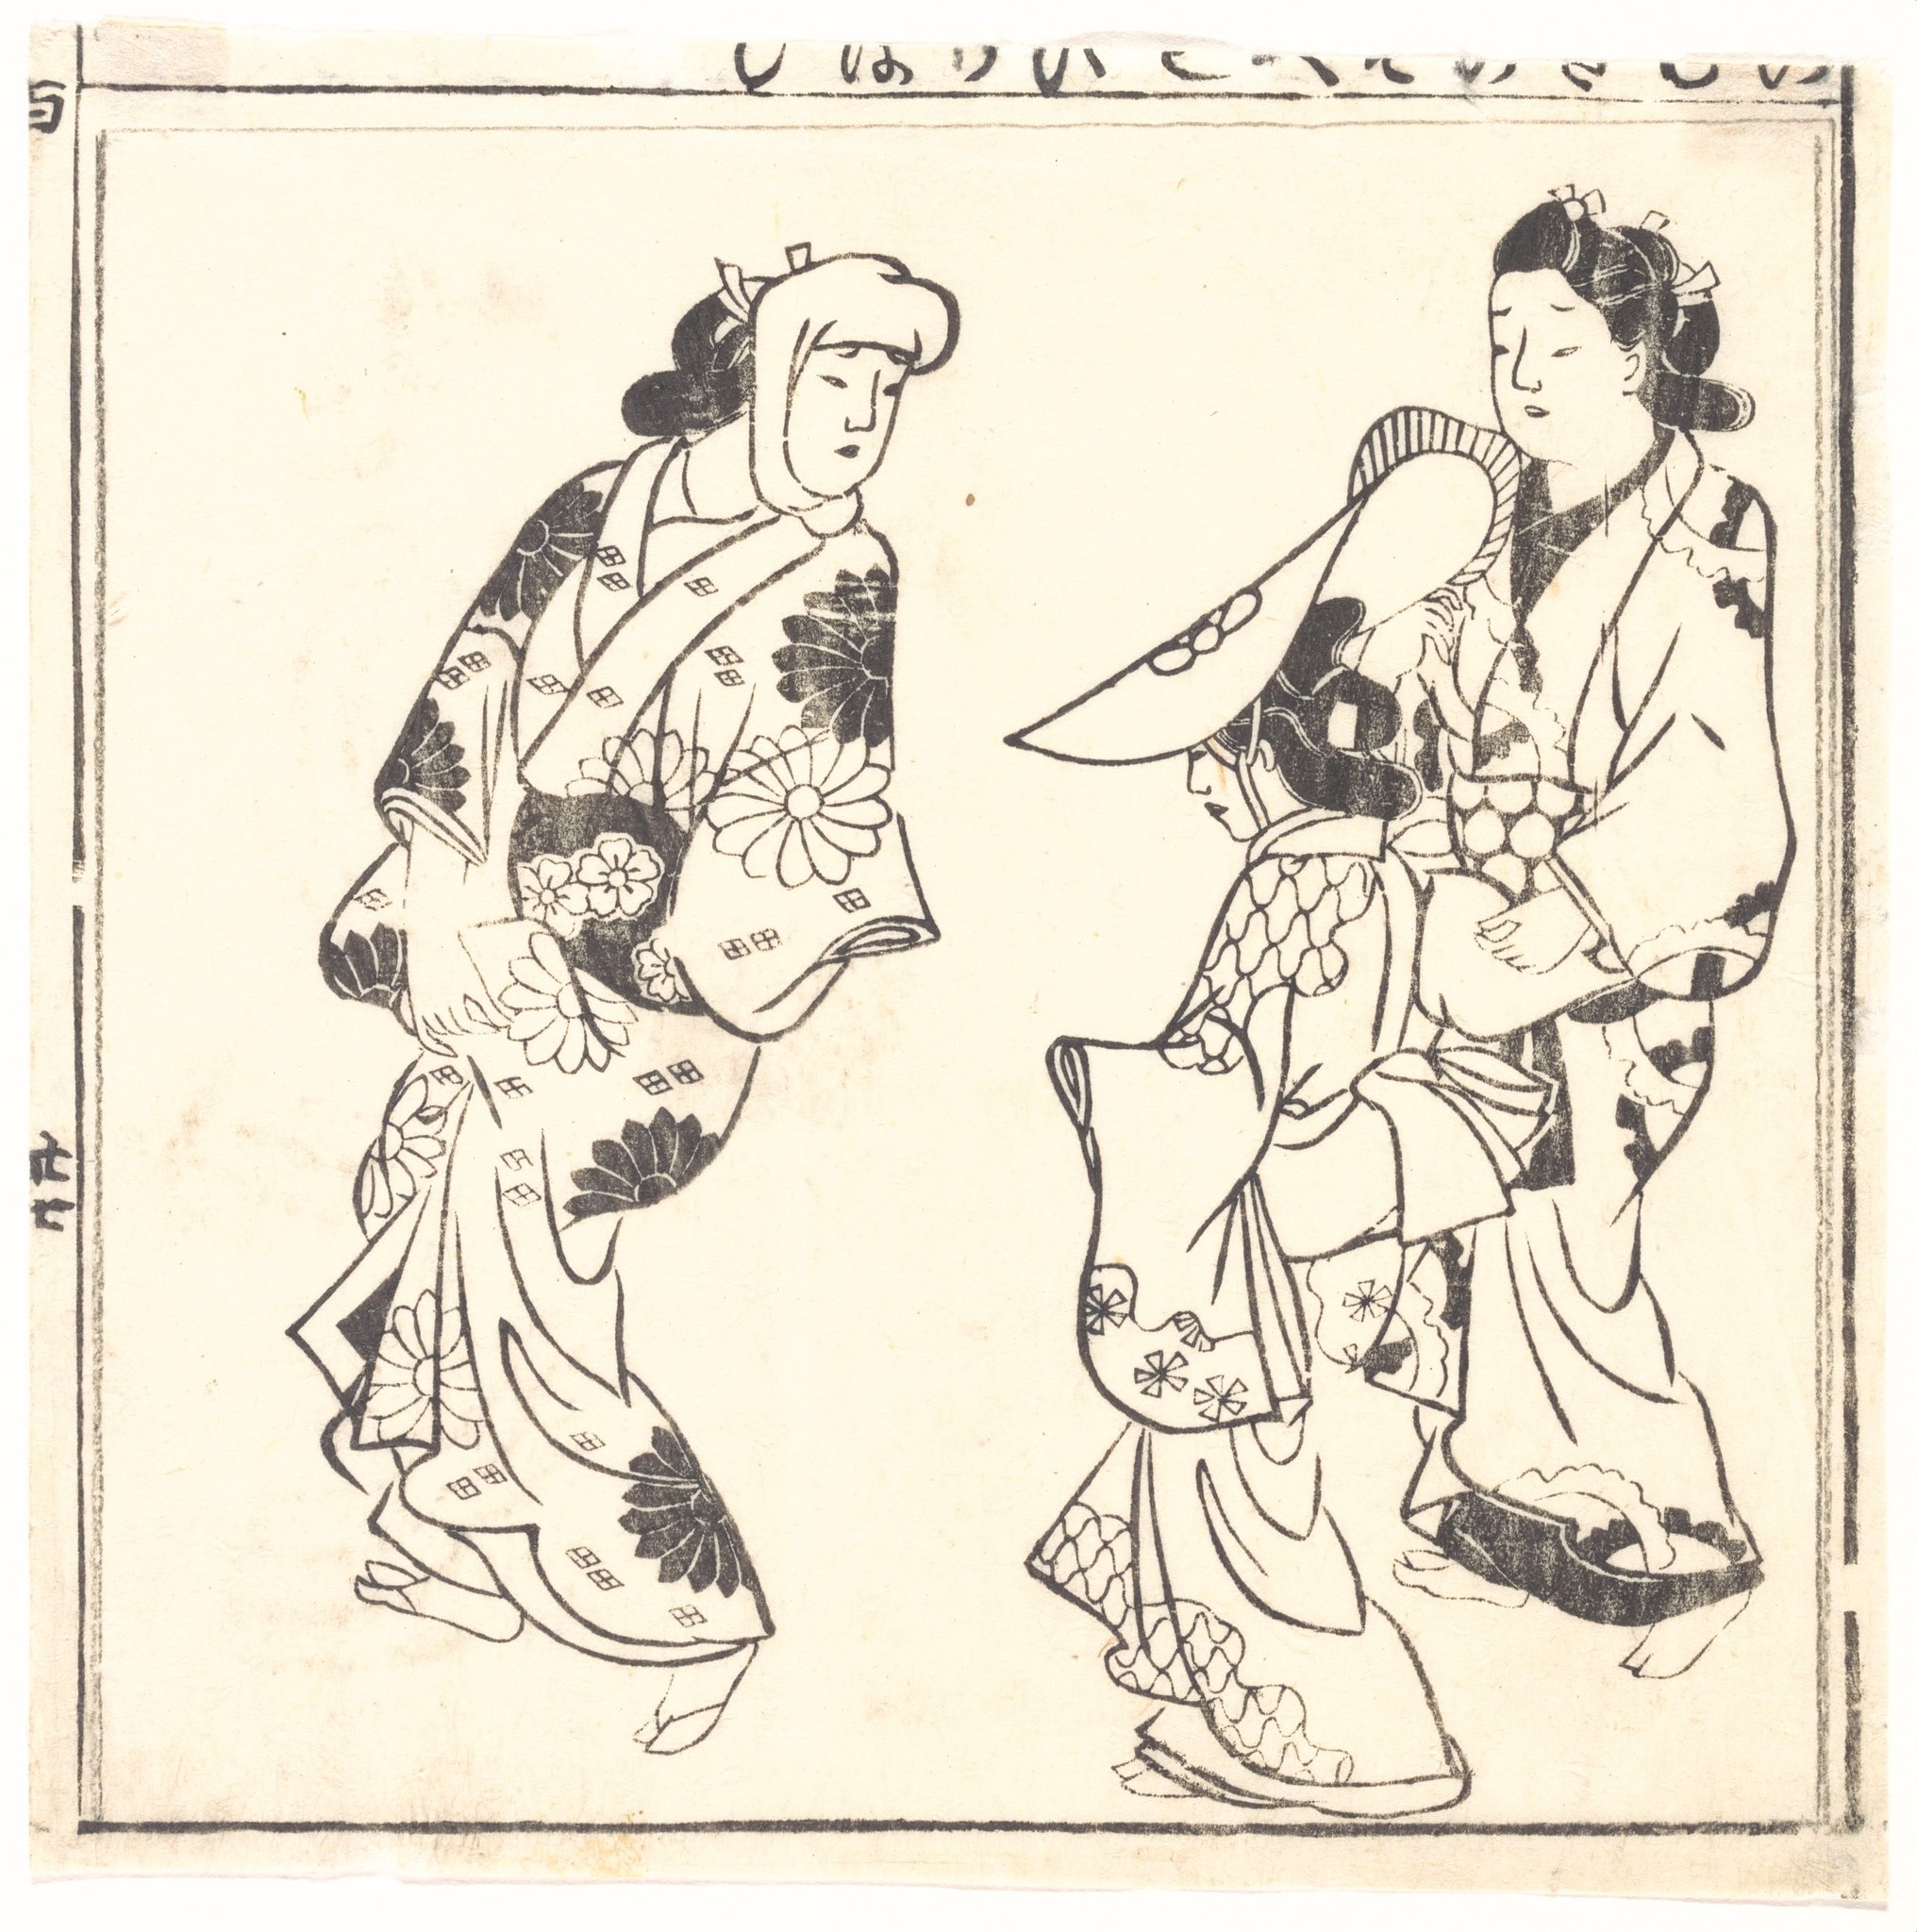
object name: print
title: Leaf from One Hundred Japanese Women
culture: japanese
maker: hishikawa moronobu 菱川師宣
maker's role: artist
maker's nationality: japanese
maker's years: 1618-1694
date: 1695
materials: ink, paper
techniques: woodblock print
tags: women